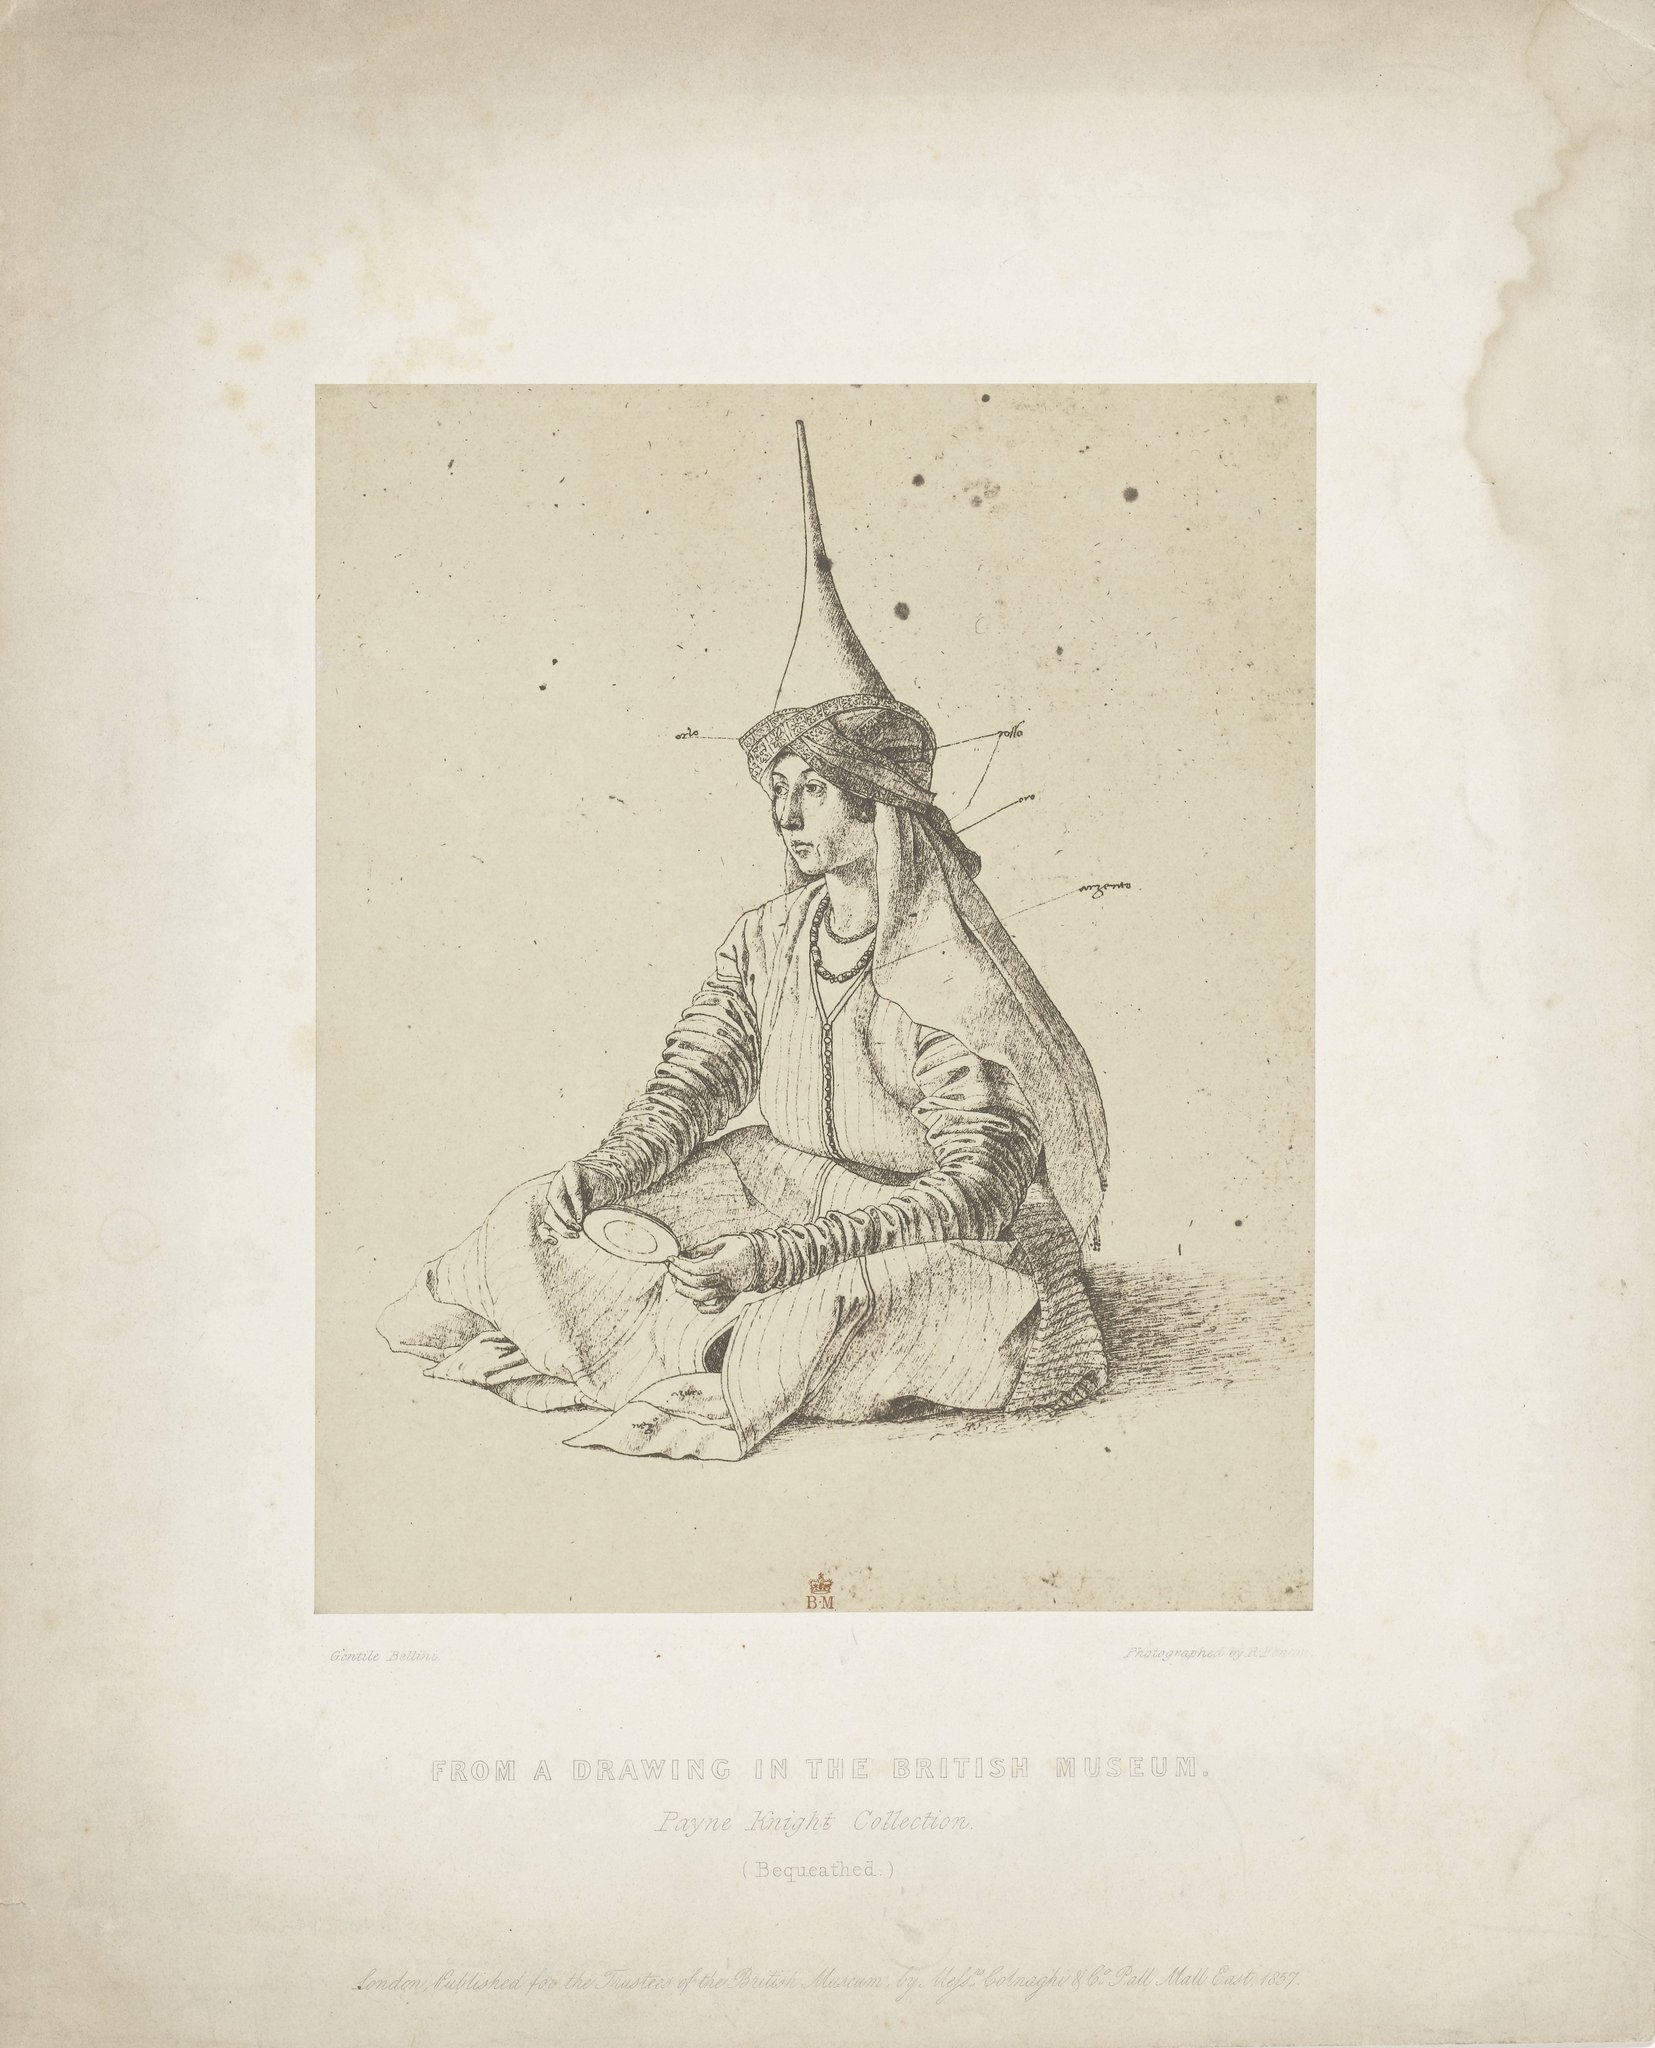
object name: reproduction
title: From a drawing in the British museum, Payne Knight Collection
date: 1857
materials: paper, photographic support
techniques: salted paper print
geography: great britain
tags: adult woman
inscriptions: inscription: ‘(Bequeathed.)/ London, Published for the Trustees of the British Museum, by Messrs. Colnaghi & Co. Pall Mall East, 1857.’